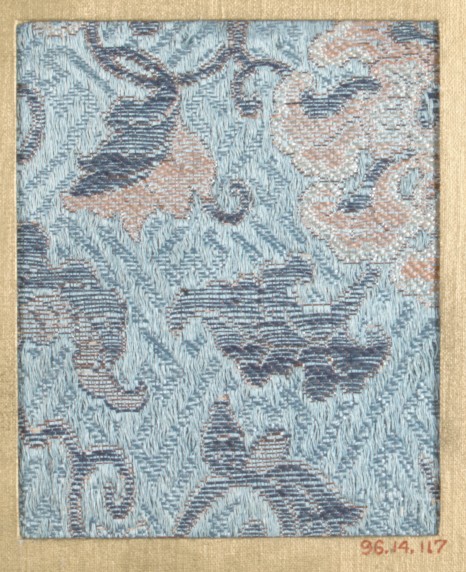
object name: piece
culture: japanese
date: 1701-1900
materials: silk